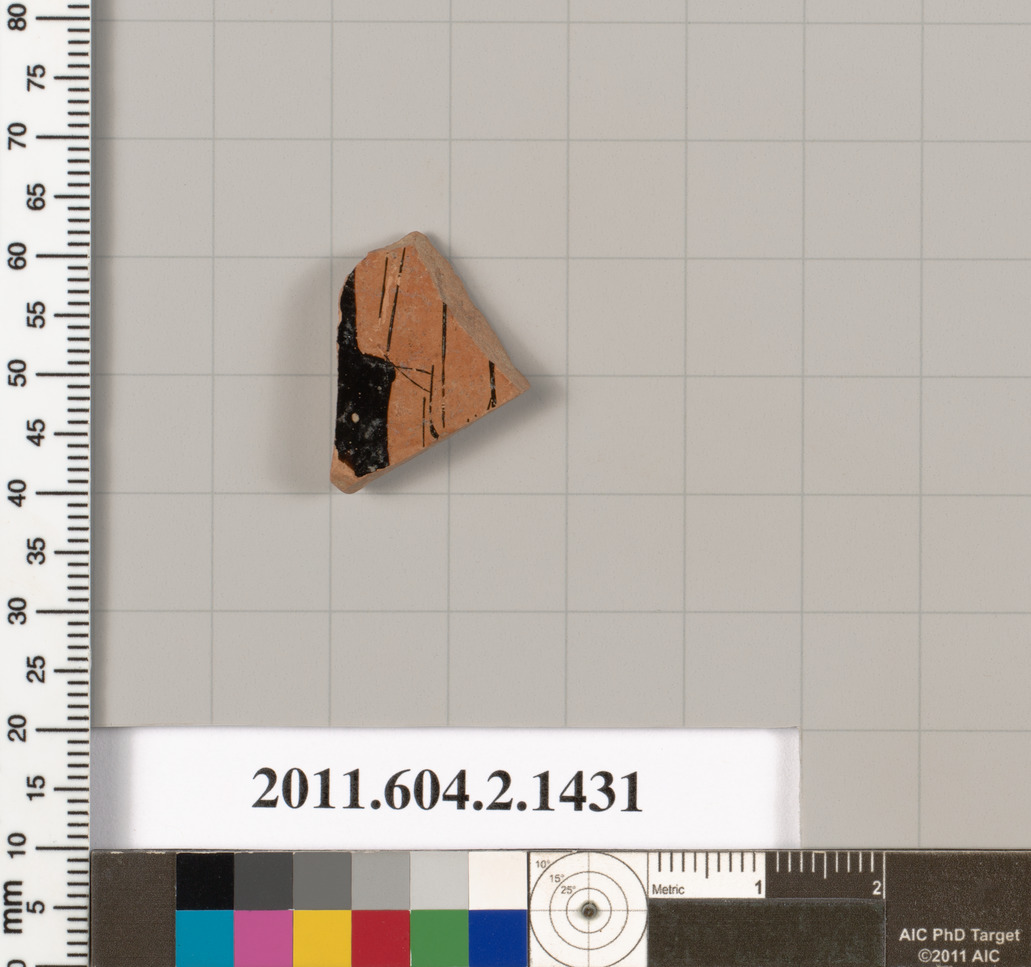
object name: skyphos fragment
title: Terracotta fragment of a skyphos (deep drinking cup)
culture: greek, attic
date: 450-440 BCE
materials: terracotta